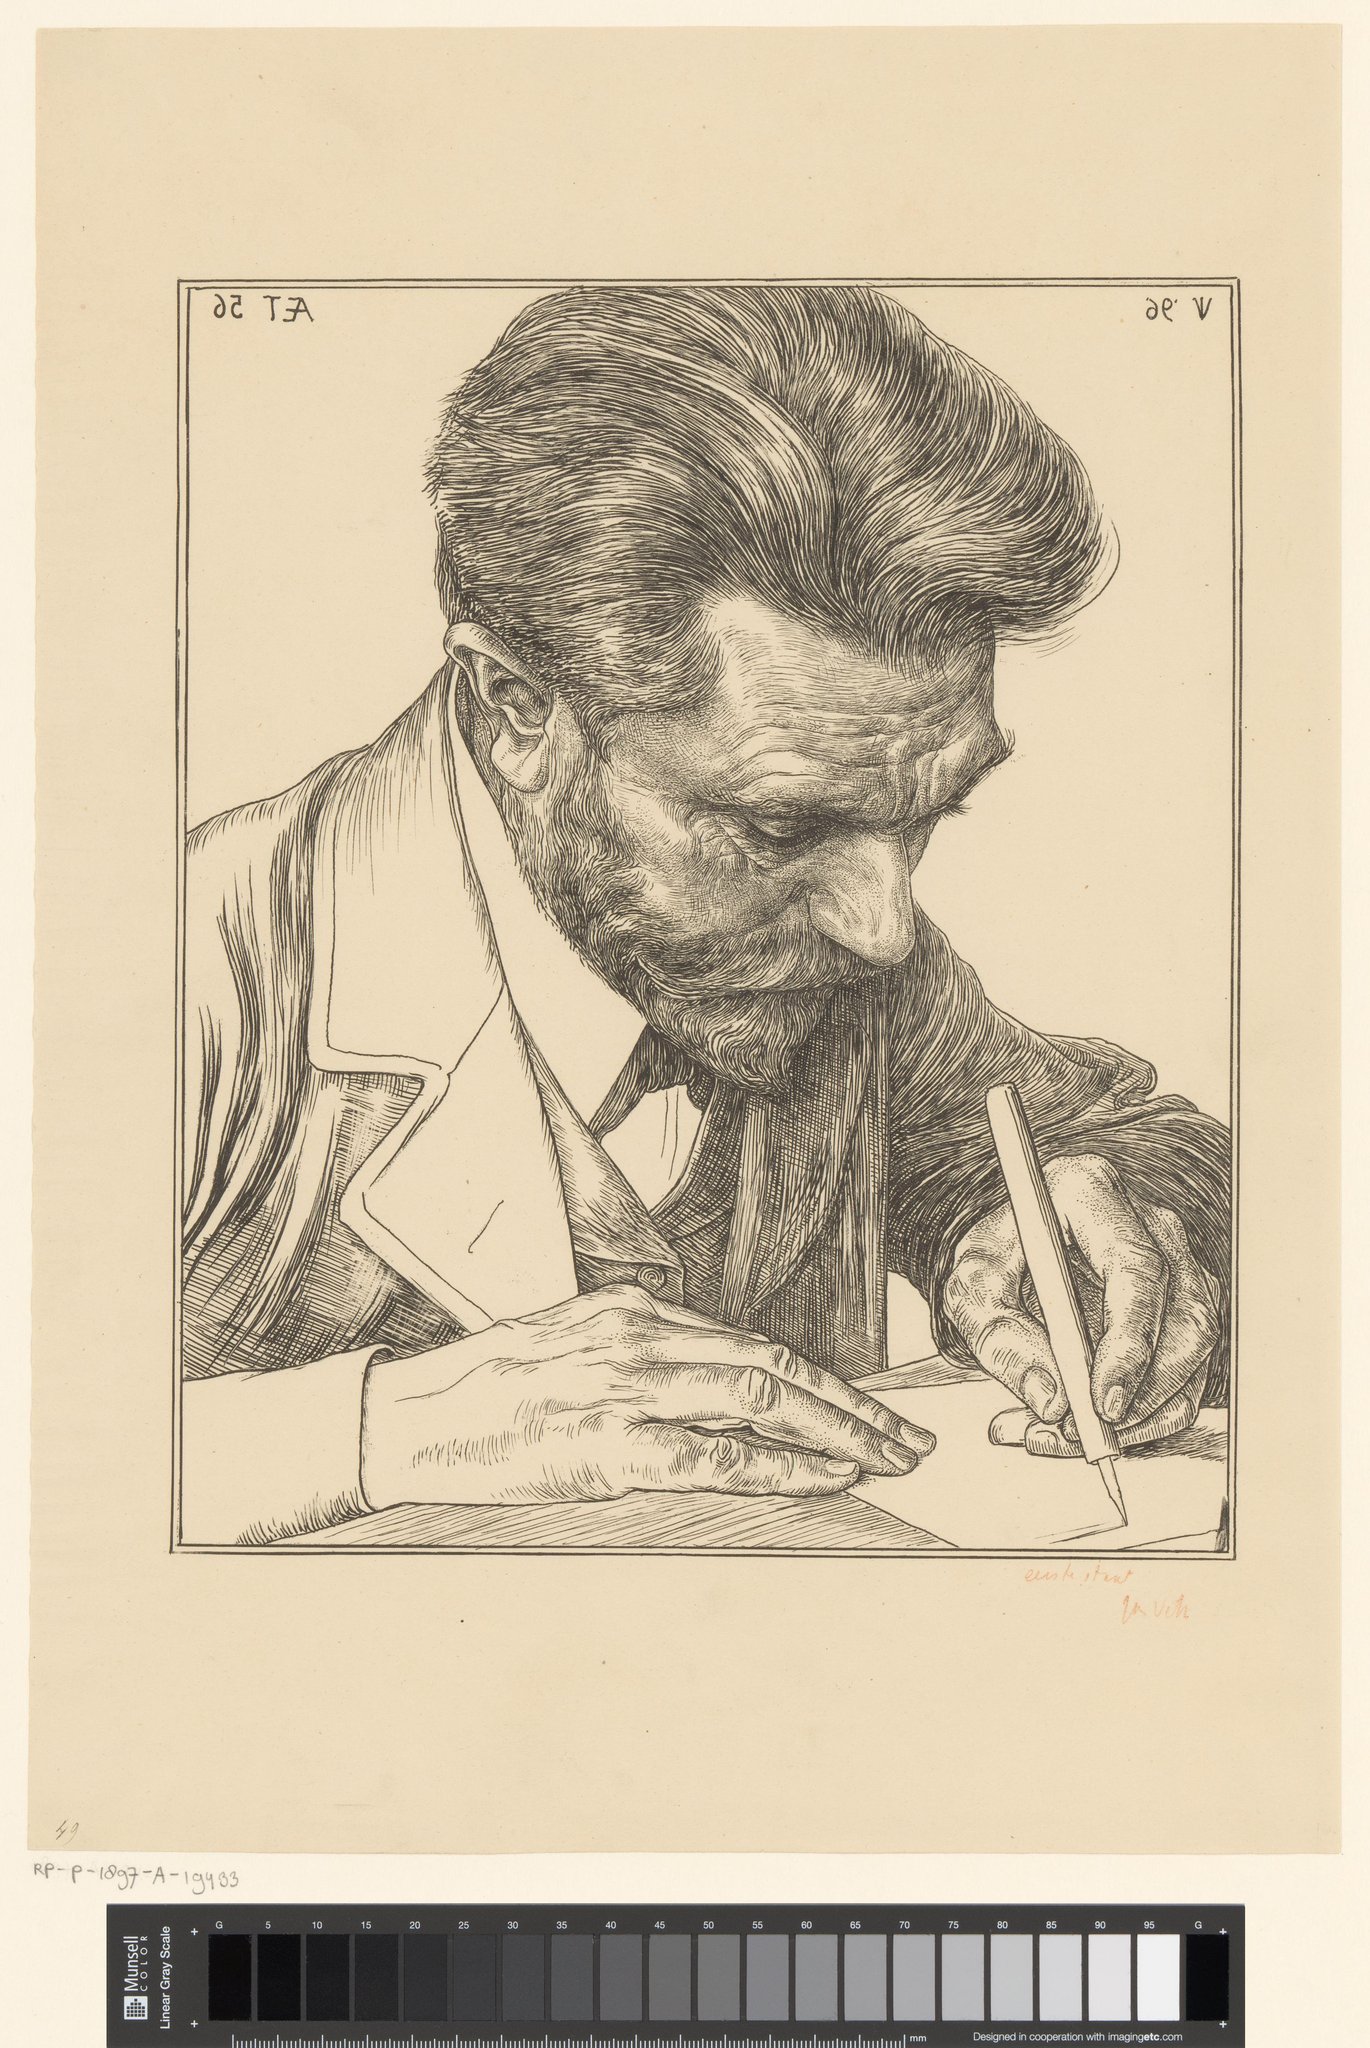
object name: print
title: Portret van August Bebel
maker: jan veth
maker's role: designer, draughtsman, painter, print maker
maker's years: 1864-1925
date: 1896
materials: paper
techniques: lithograph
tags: politician, writing tools, historical persons (+ (full) bust portrait)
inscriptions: inscription: ‘eerste staat / Jan Veth’, collector's mark: Lugt 2228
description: Dit portret werd uitgegeven als bijvoegsel bij De Kroniek op 3 mei 1896.